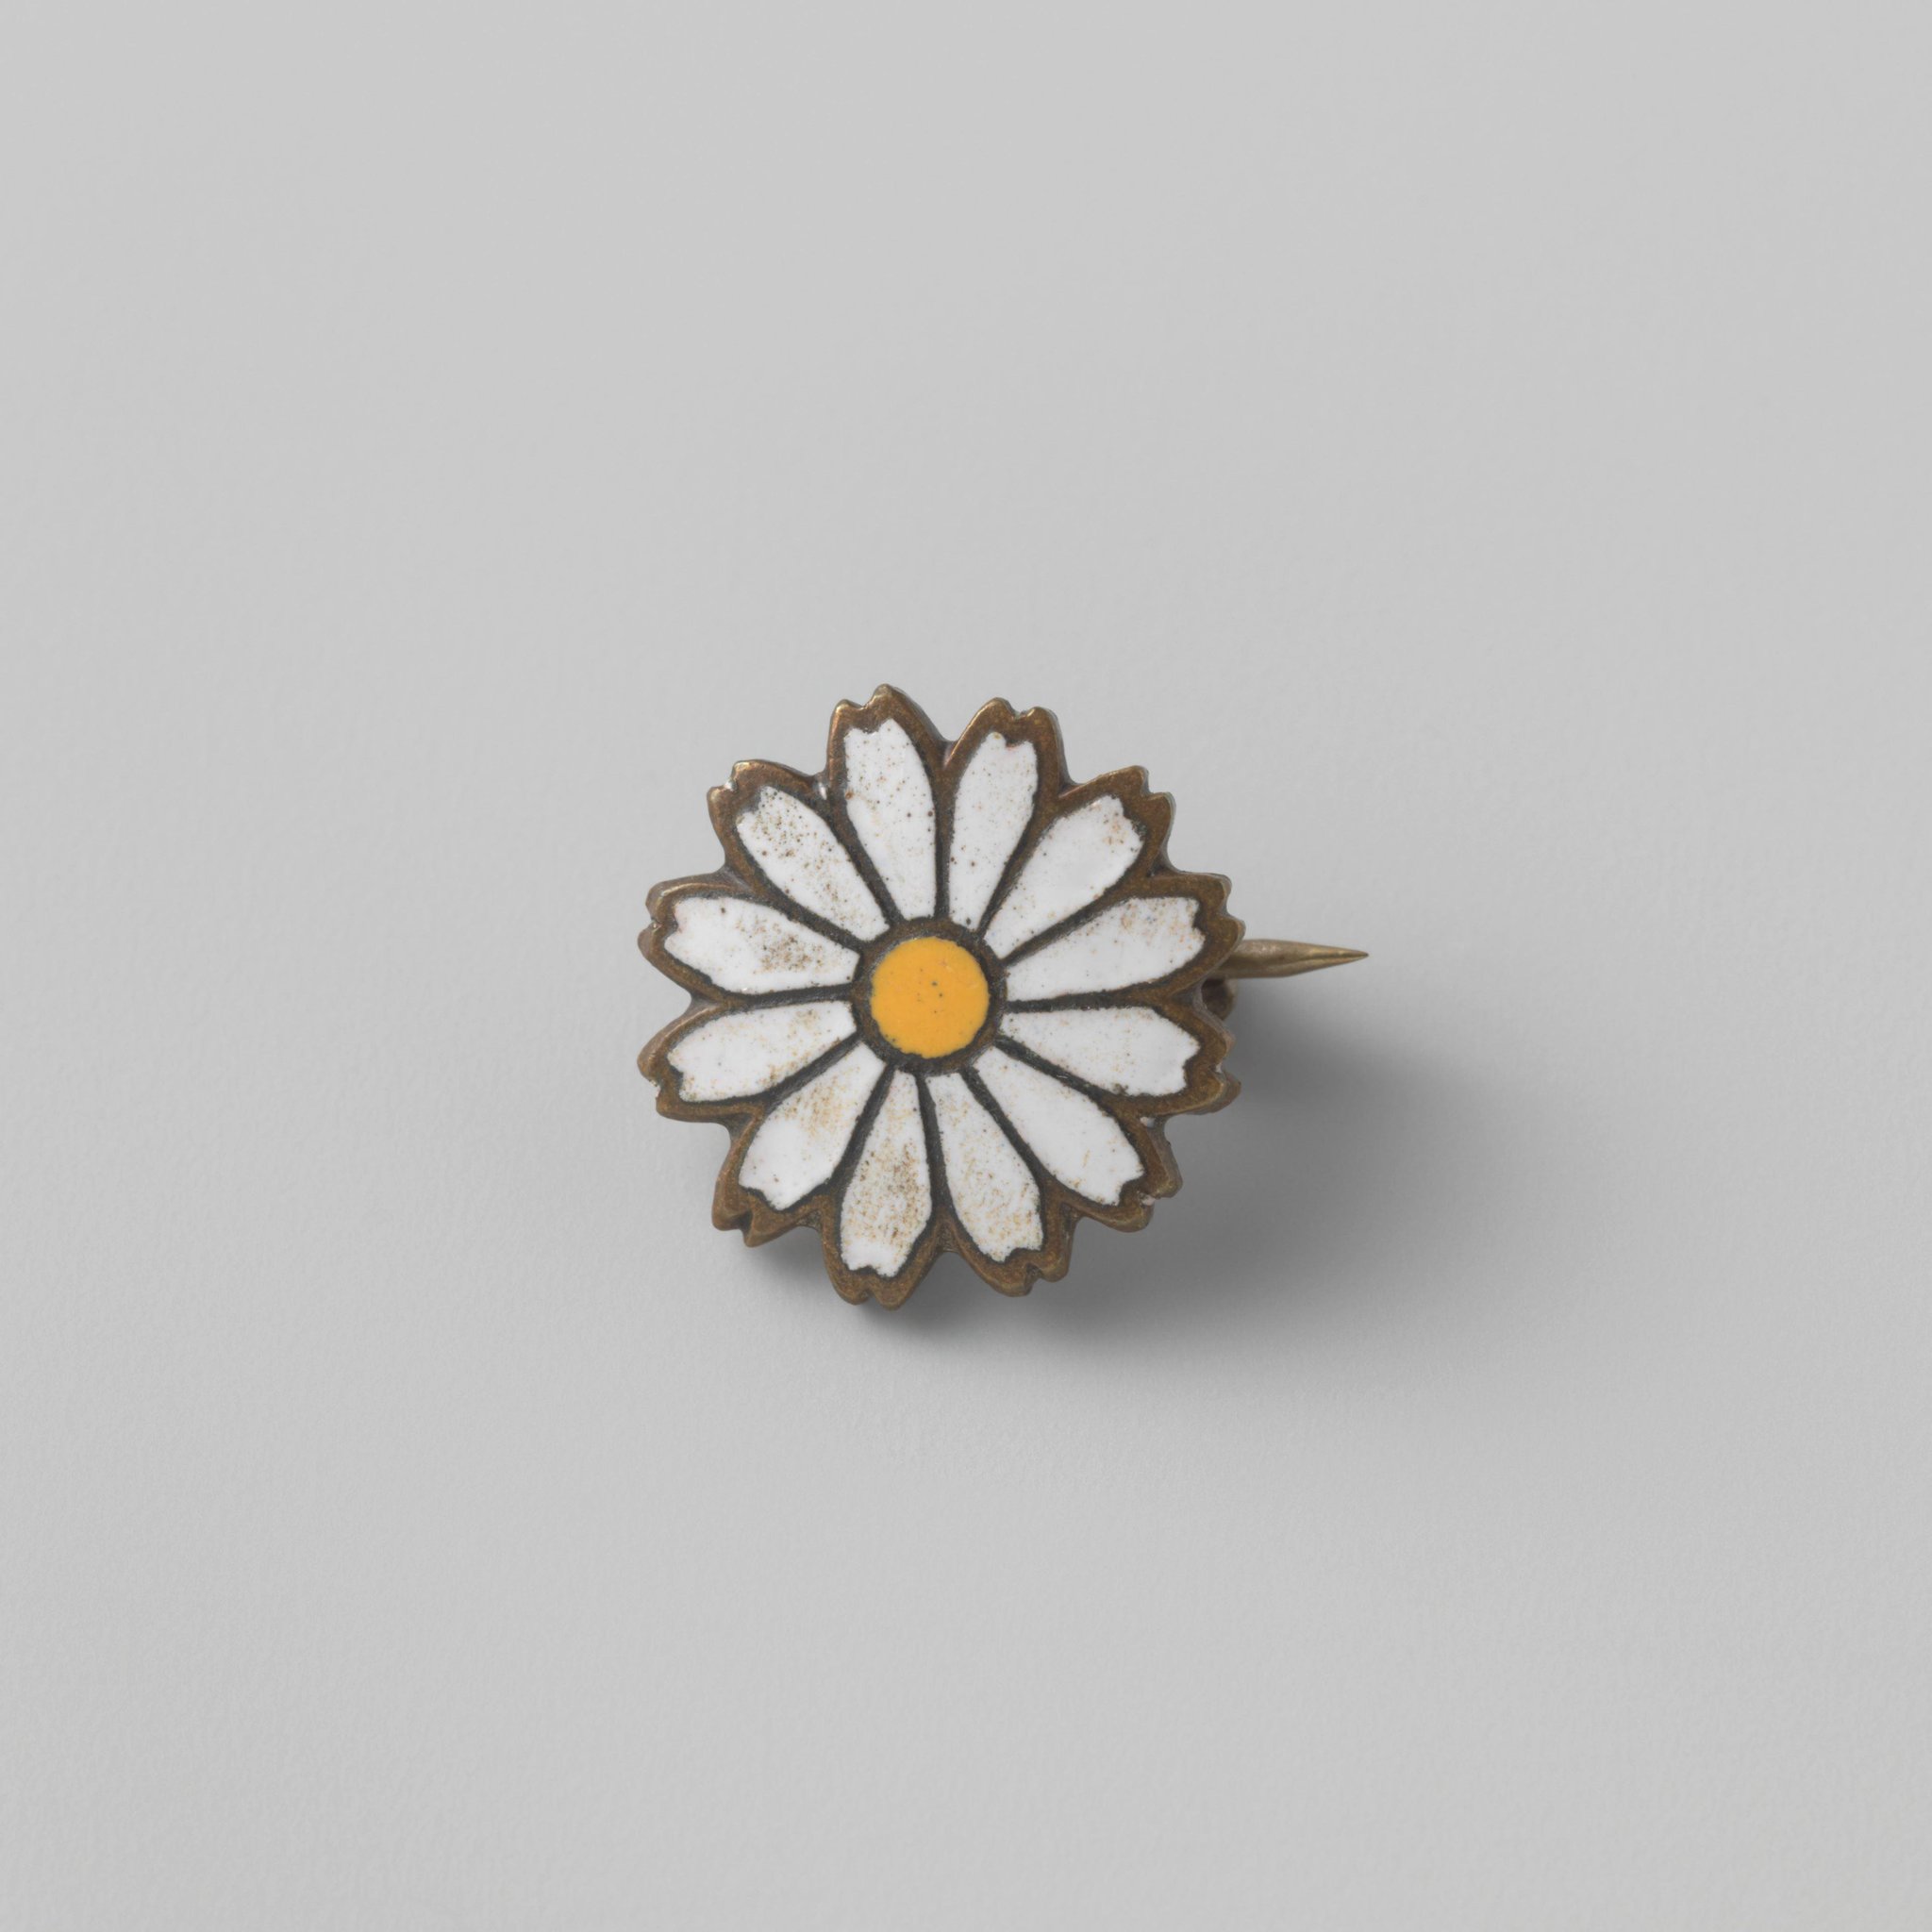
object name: brooch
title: Two brooches in the form of a daisy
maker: Anonymous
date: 1945-1955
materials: metal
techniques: enameling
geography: netherlands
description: Silent Resistance –War and Liberation Jewellery During the Second World War, small pieces of jewellery were worn in the Netherlands as a silent protest against the German occupier. In April 1941, Dutch coins were officially confiscated for the war industry. As jewellery did not have to be surrendered, coins were quickly transformed into rings, brooches, pins and bracelets. A portrait of Queen Wilhelmina was worn as a sign of resistance, as well as a token of loyalty to the royal family. Margriet Francisca, the third daughter of Princess Juliana and Prince Bernard, was born in Canada in January 1943. The pin with the three yellow chicks refers to the three young princesses Beatrix, Irene and Margriet and the steadfastness of the Dutch royal family. After the liberation, coins and silver were used for jewellery conveying messages of hope for a peaceful future.